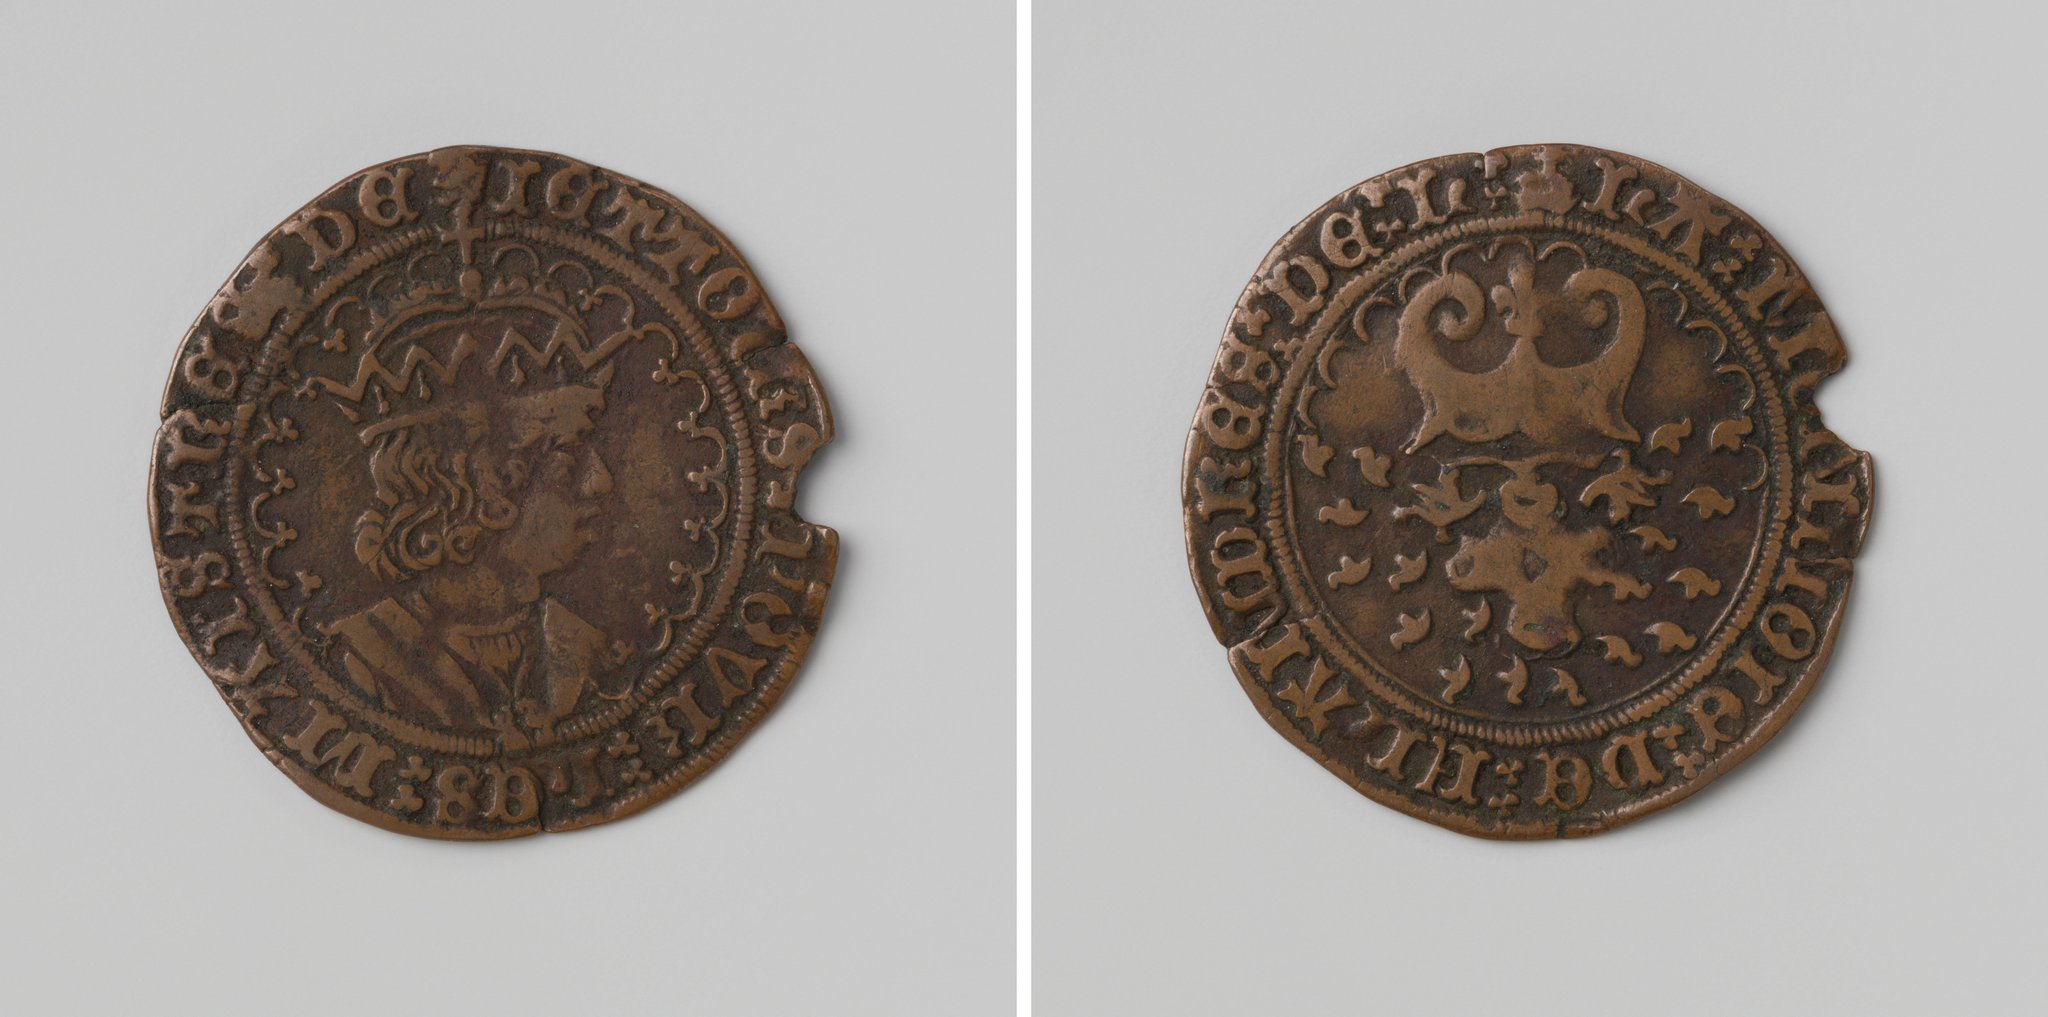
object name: jeton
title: Huwelijk van Filips de Schone, hertog van Bourgondie met Johanna, prinses van Castillie, rekenpenning van de muntmeesters van Vlaanderen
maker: Anonymous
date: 1496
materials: copper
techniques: striking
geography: flanders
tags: bruges, filips de schone (hertog van bourgondië)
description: Koperen penning. Voorzijde: borststuk gekroonde man binnen uit verschillende bogen bestaande cirkel en omschrift. Keerzijde: vuurslag, waar vonken uitschieten binnen uit verschillende bogen bestaande cirkel en omschrift